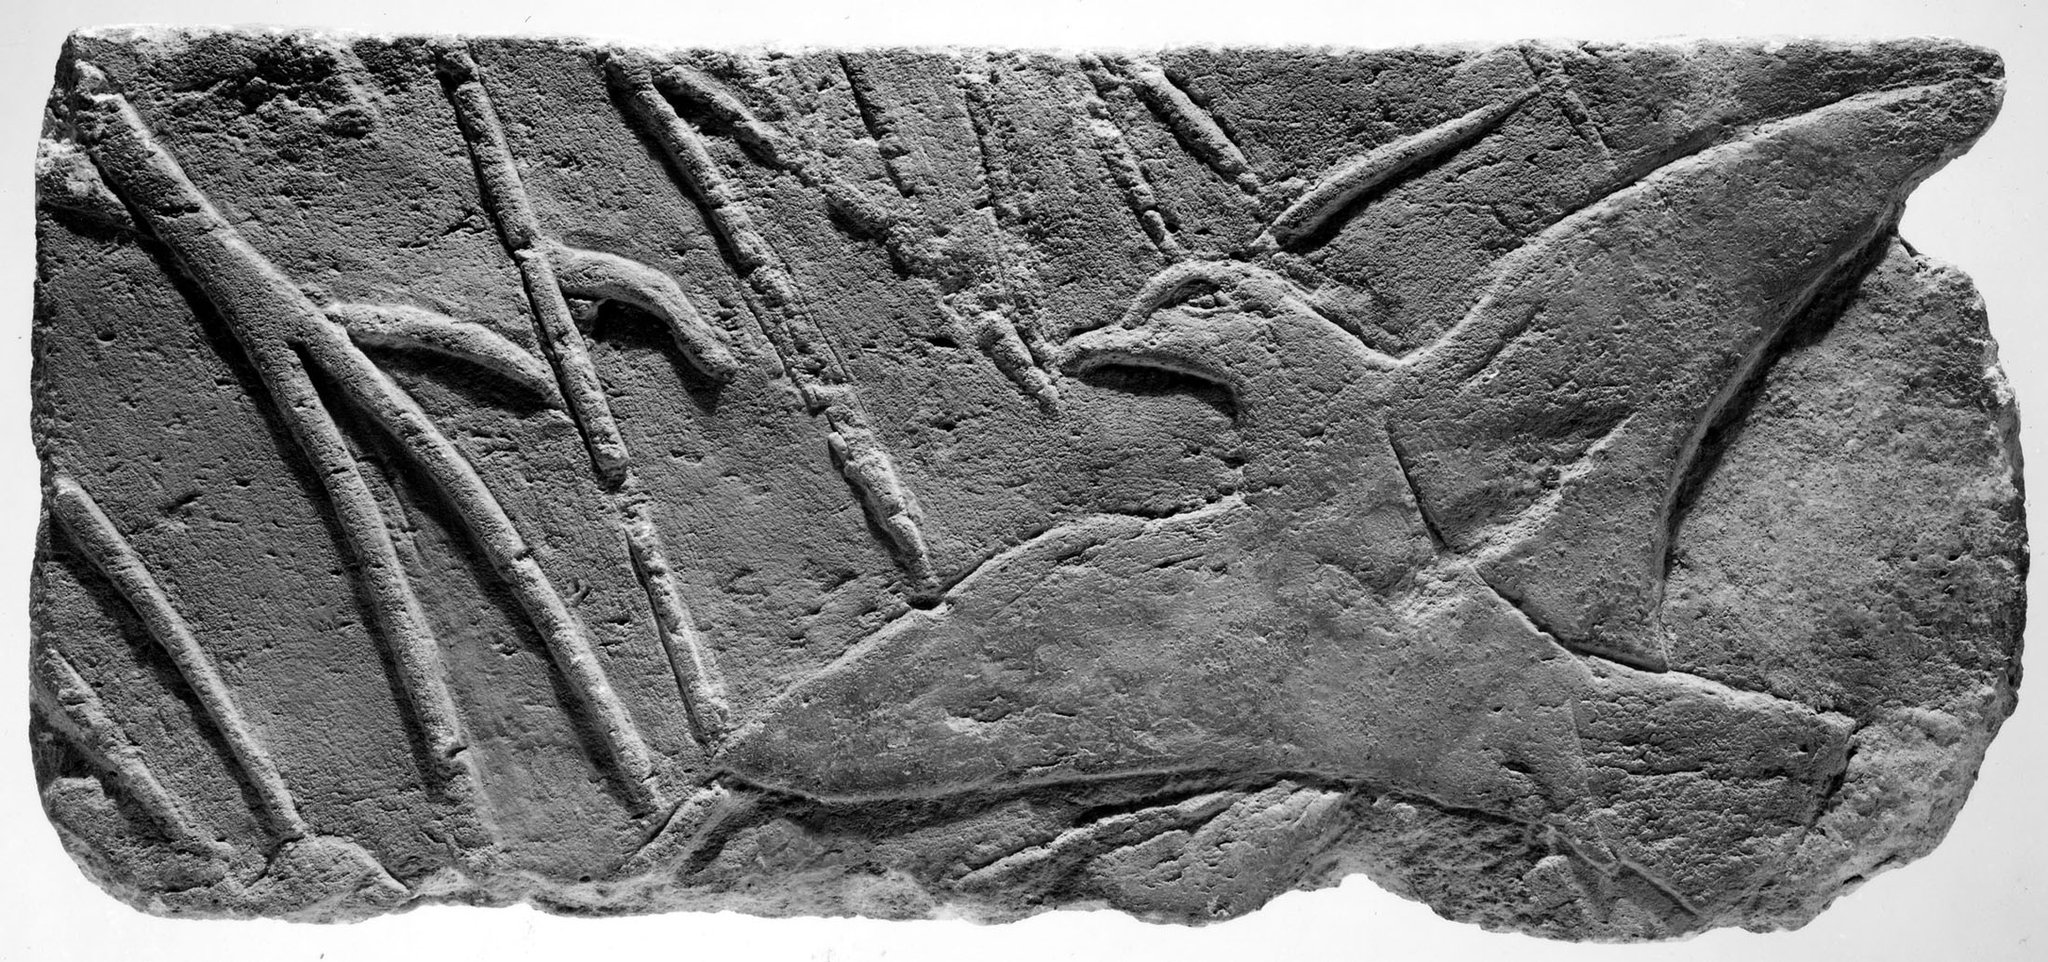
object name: talatat, bird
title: Relief with a bird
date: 1353-1336 BCE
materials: limestone, paint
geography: egypt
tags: birds